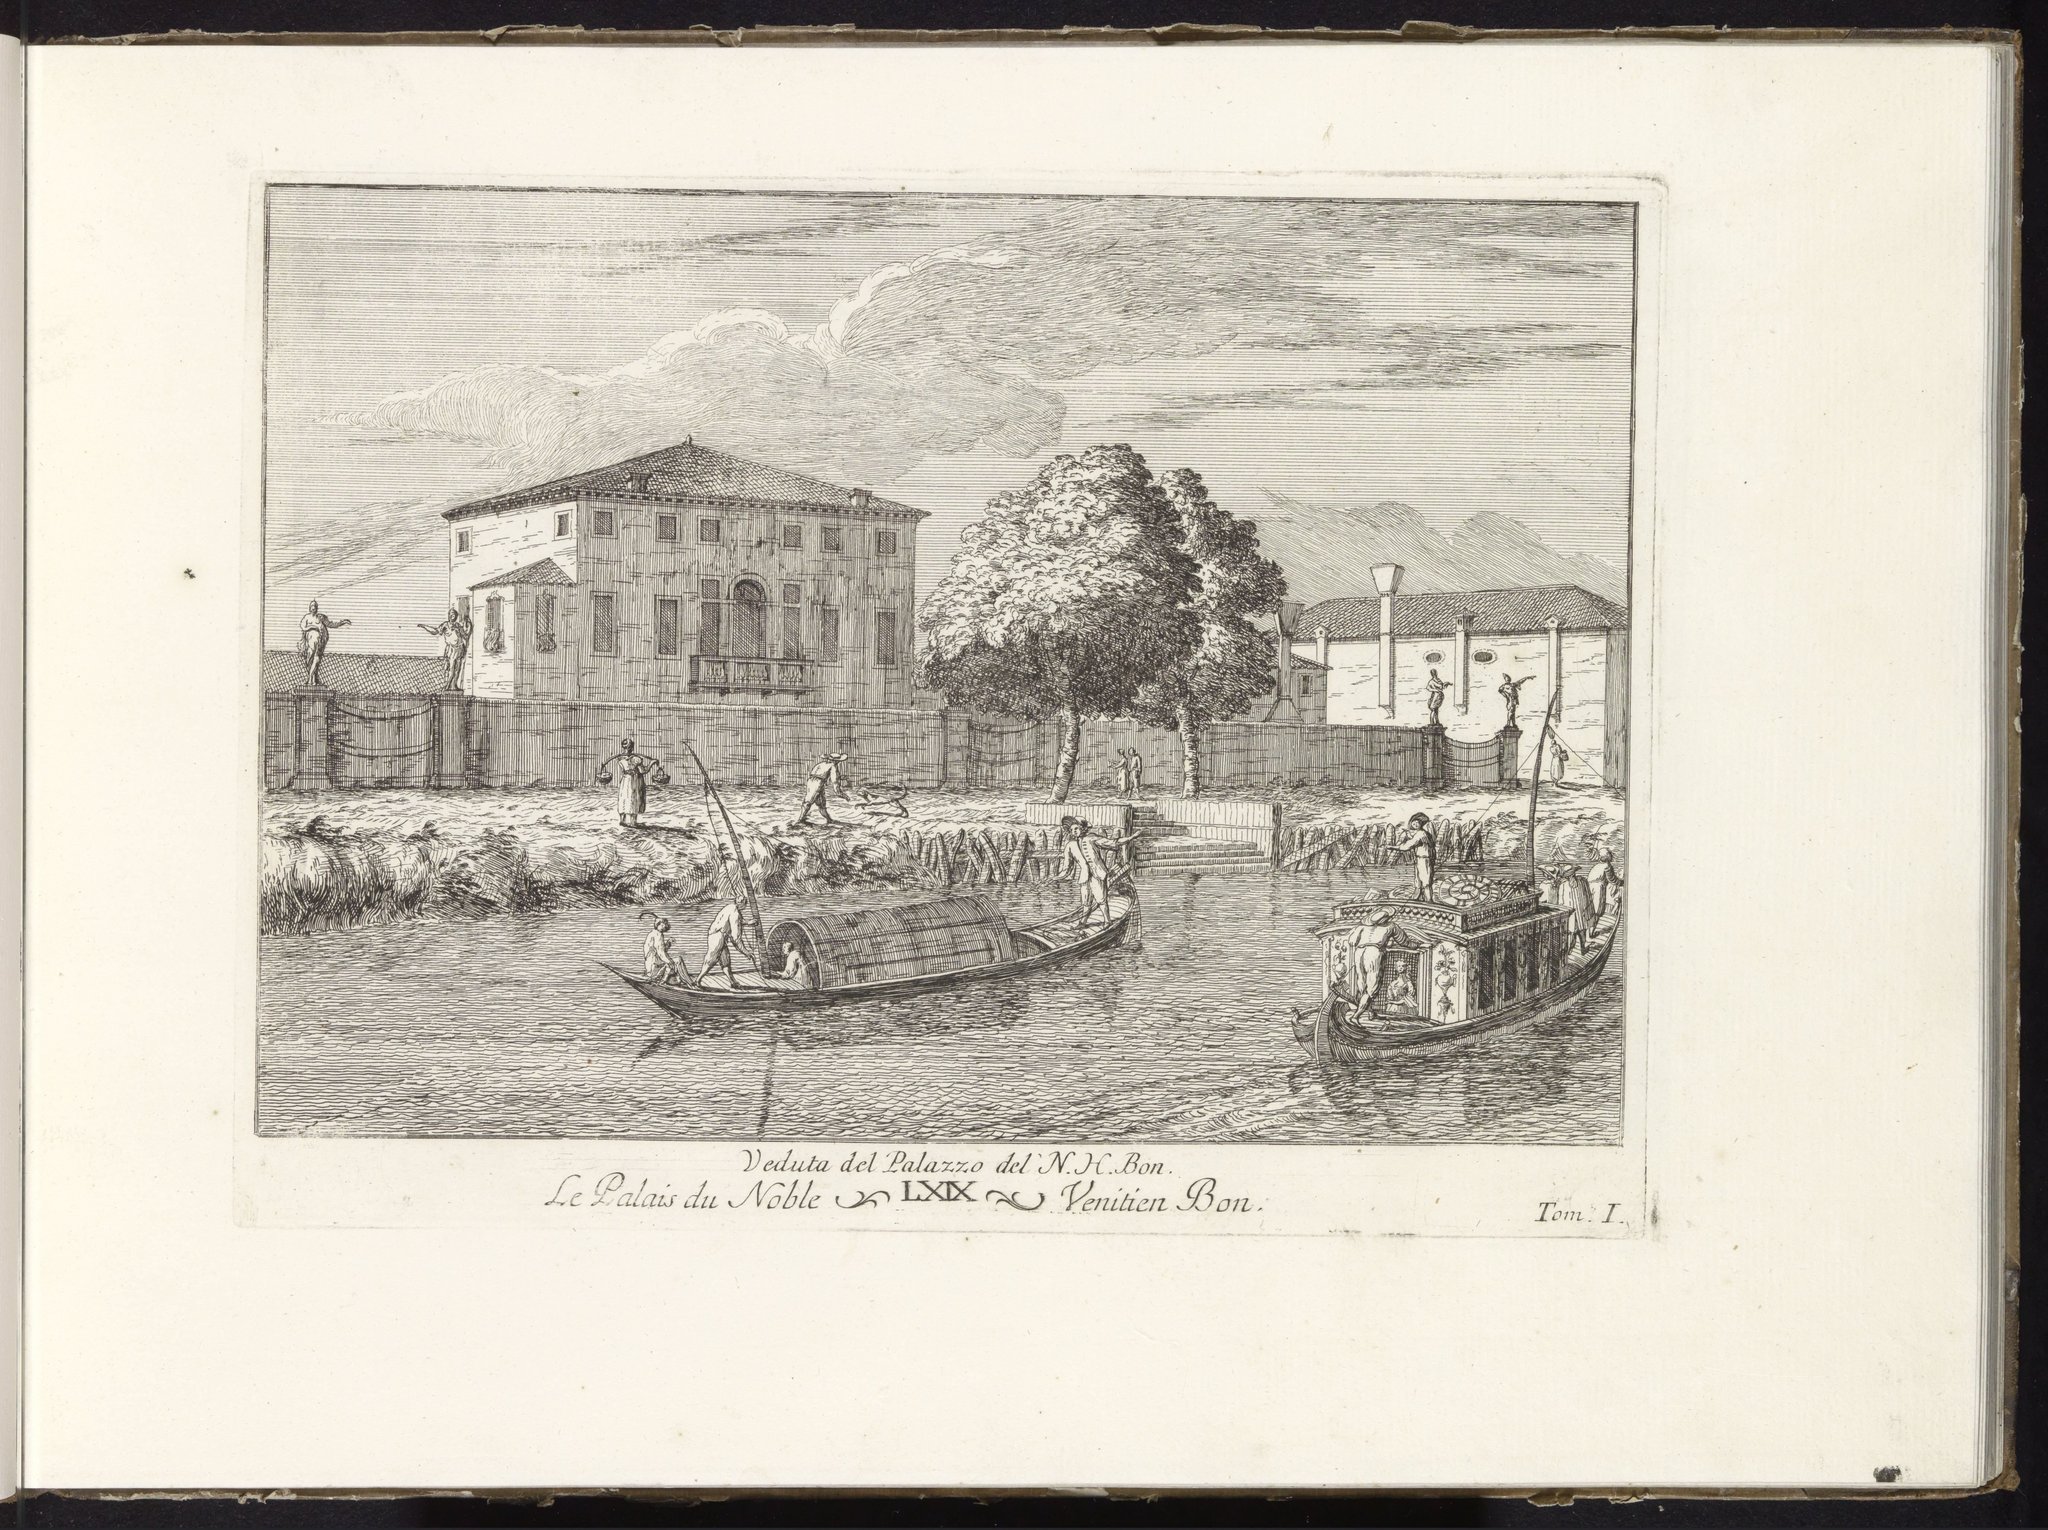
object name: print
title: Gezichten op de rivier de Brenta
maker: giovanni francesco costa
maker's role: draughtsman, painter, print maker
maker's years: -1773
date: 1750-1760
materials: paper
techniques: etching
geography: venice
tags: river, hôtel, i.e. small palace in city, gondola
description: Gezicht op Palazzo del N. H. Bon aan de rivier de Brenta. Op het water varen twee gondels. Genummerd midden onder: LXIX en rechtsonder: Tom: I. Deze prent maakt deel uit van een album.